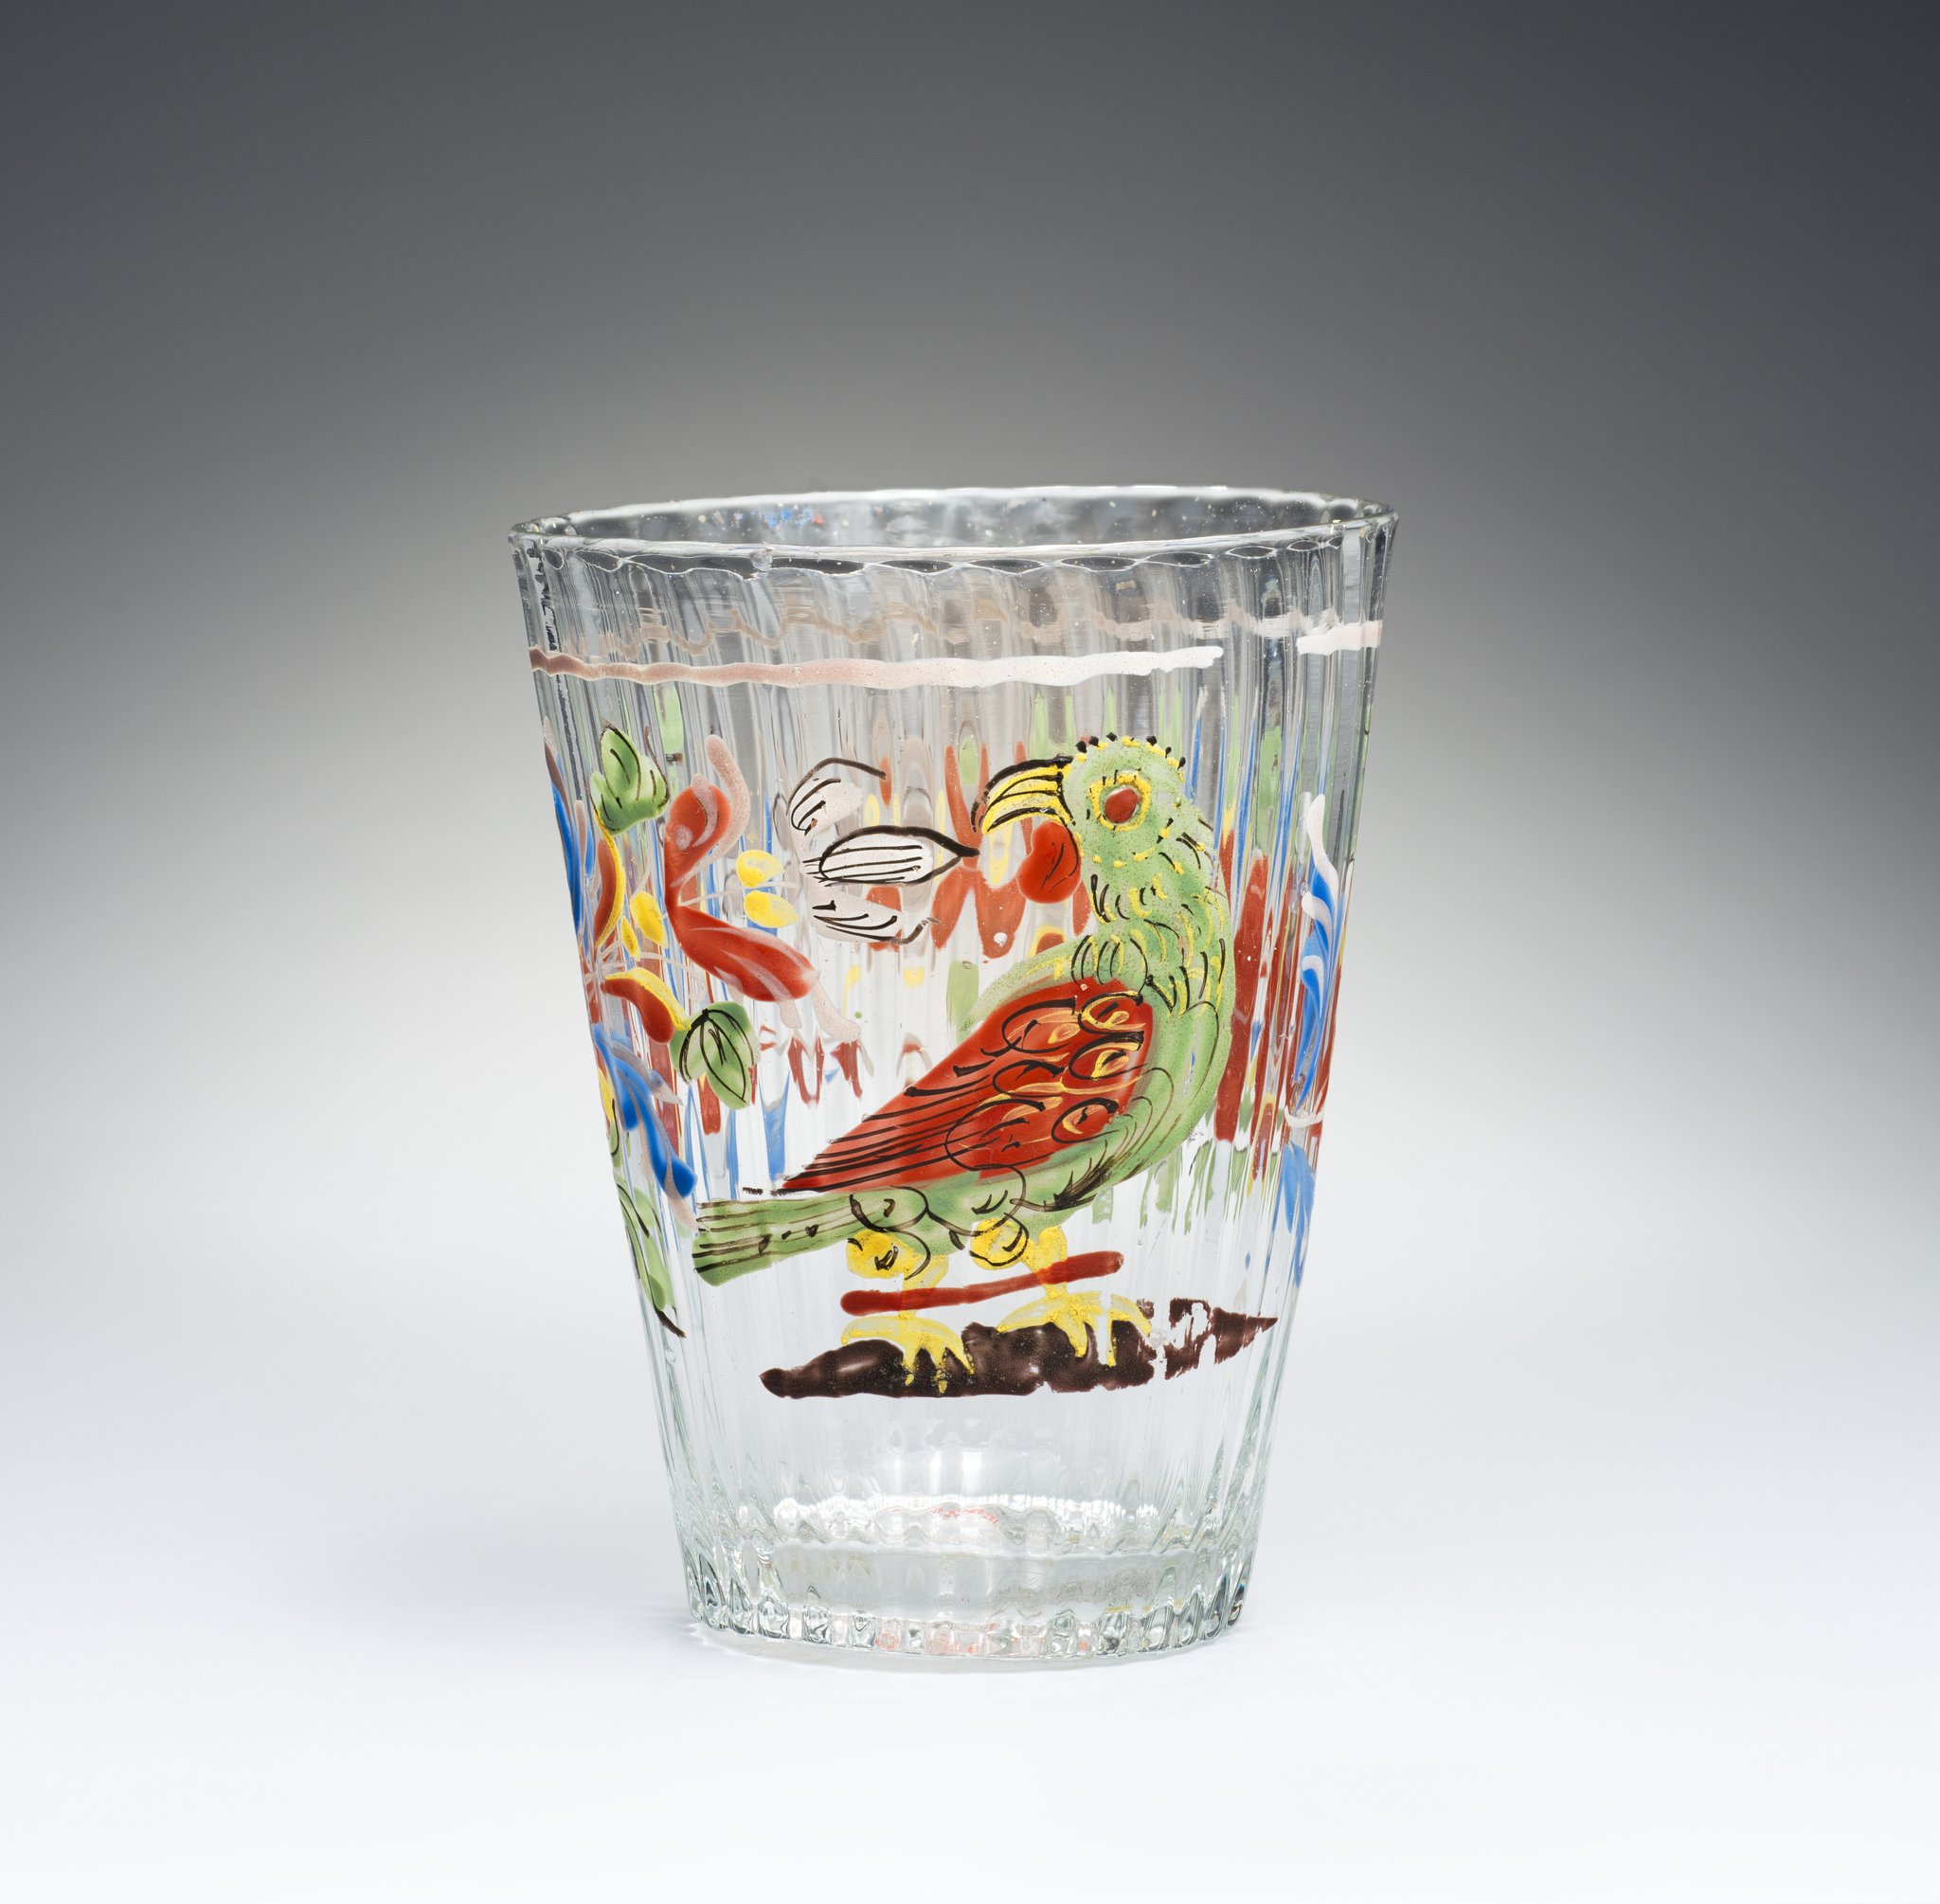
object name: tumbler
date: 1701-1800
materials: glass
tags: birds